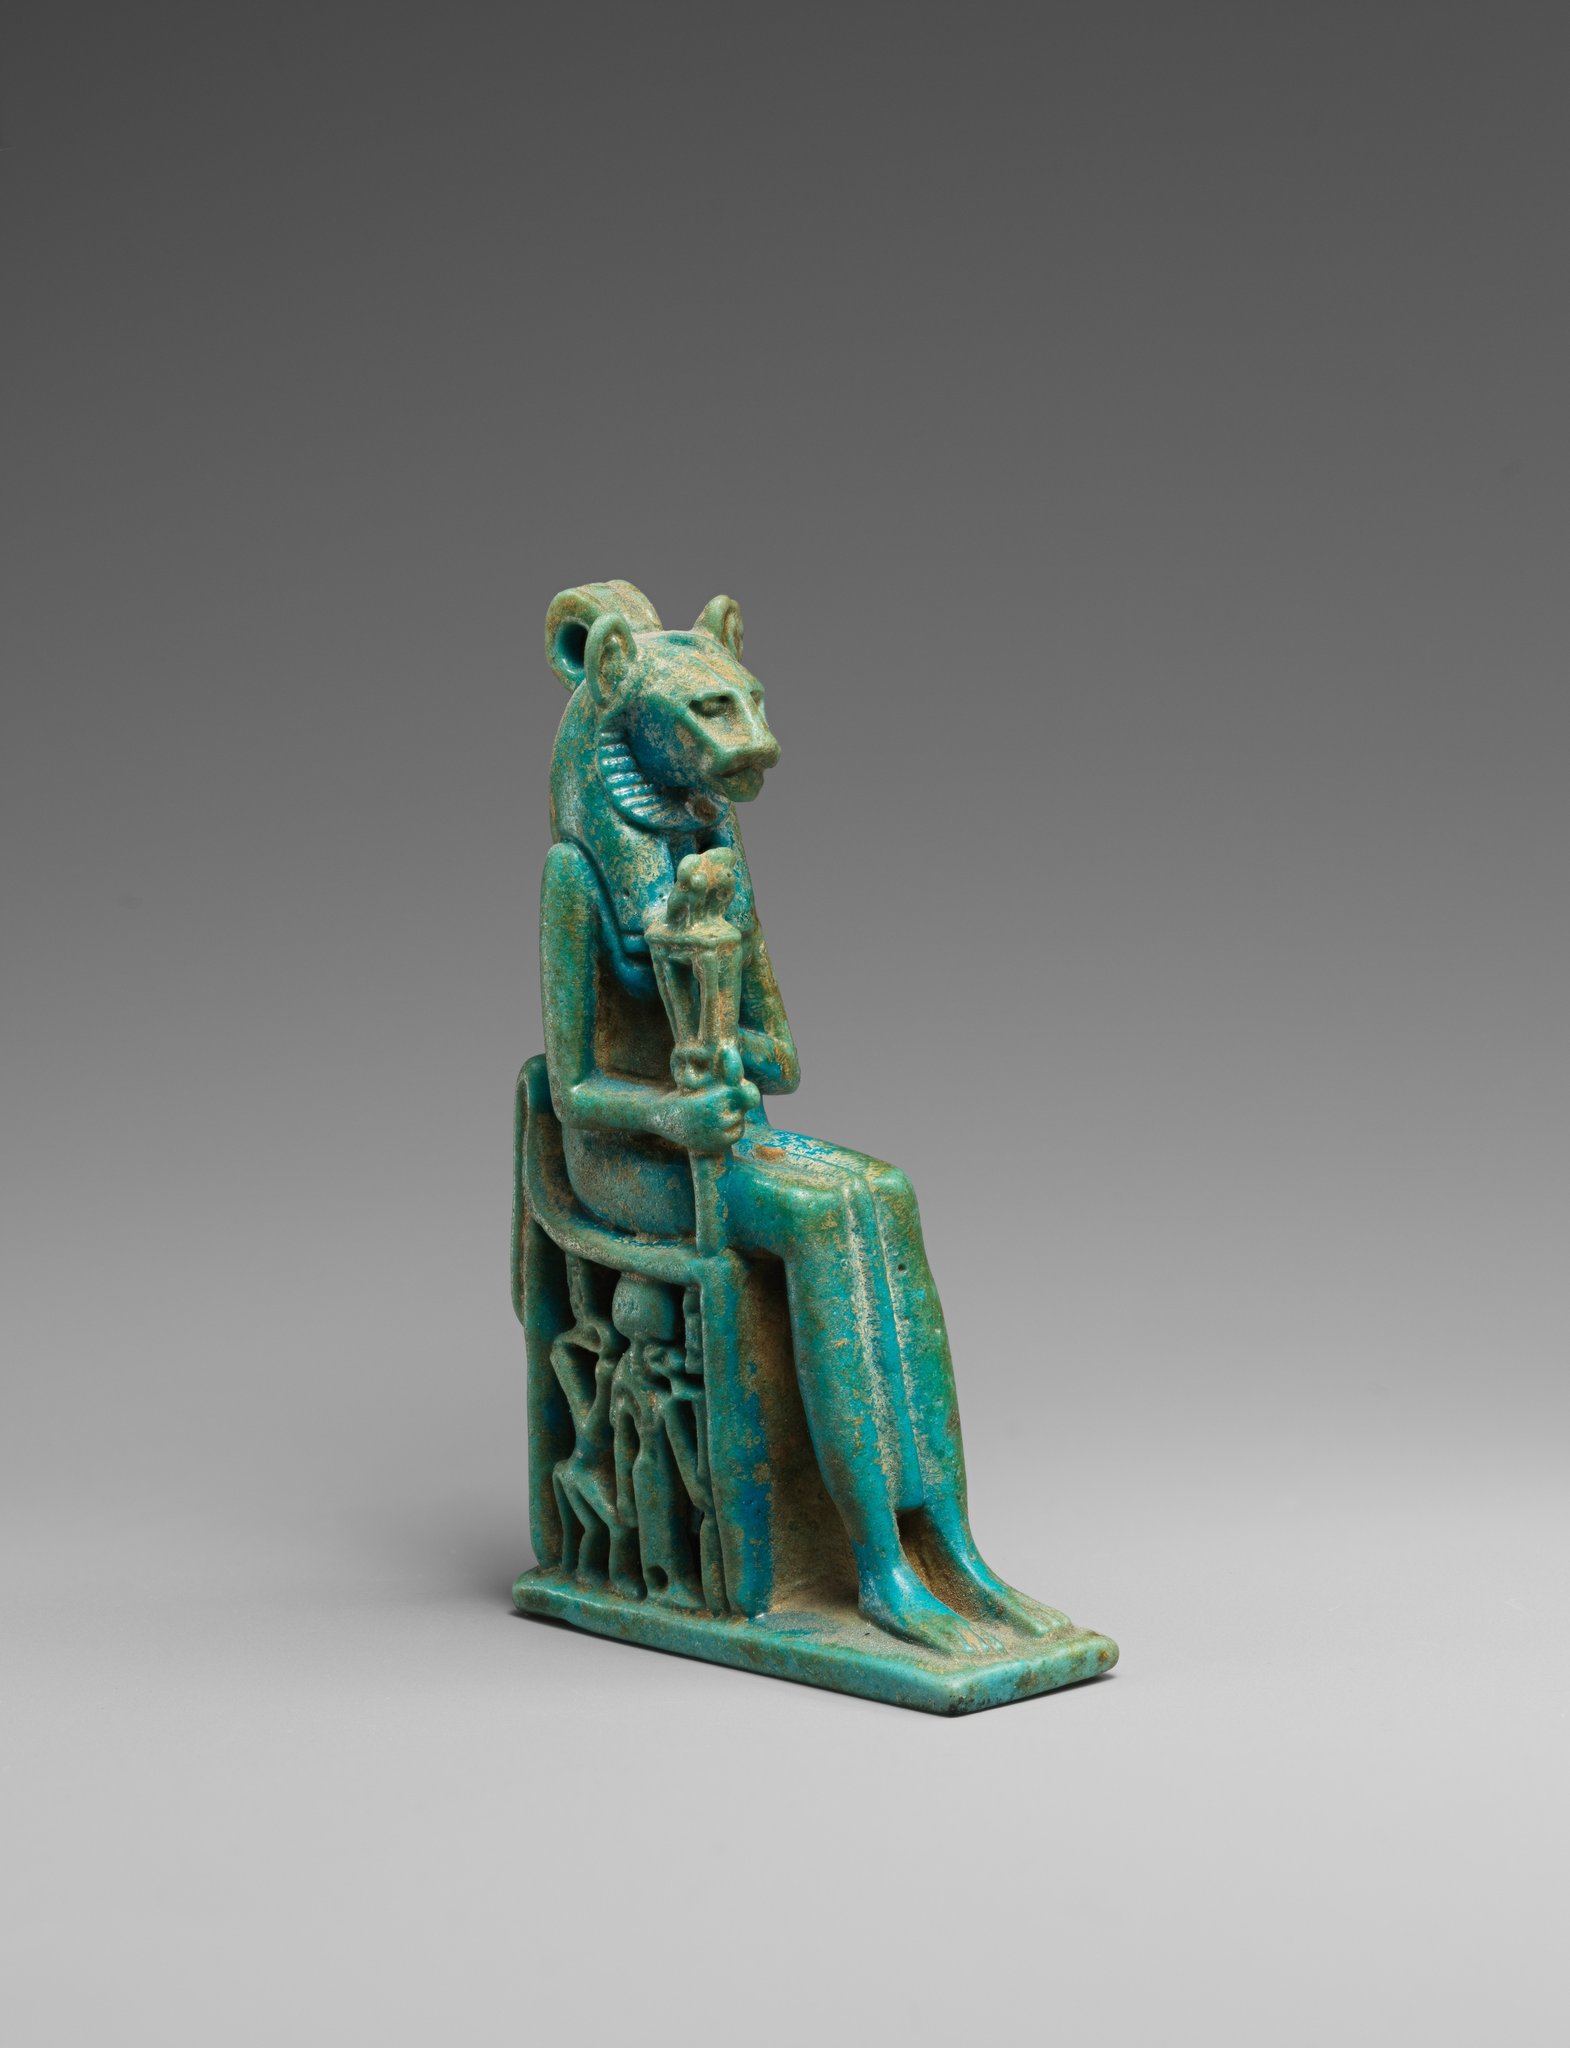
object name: amulet, lion headed deity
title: Amulet of a lion-headed Bastet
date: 872-664 BCE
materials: faience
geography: egypt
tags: goddess